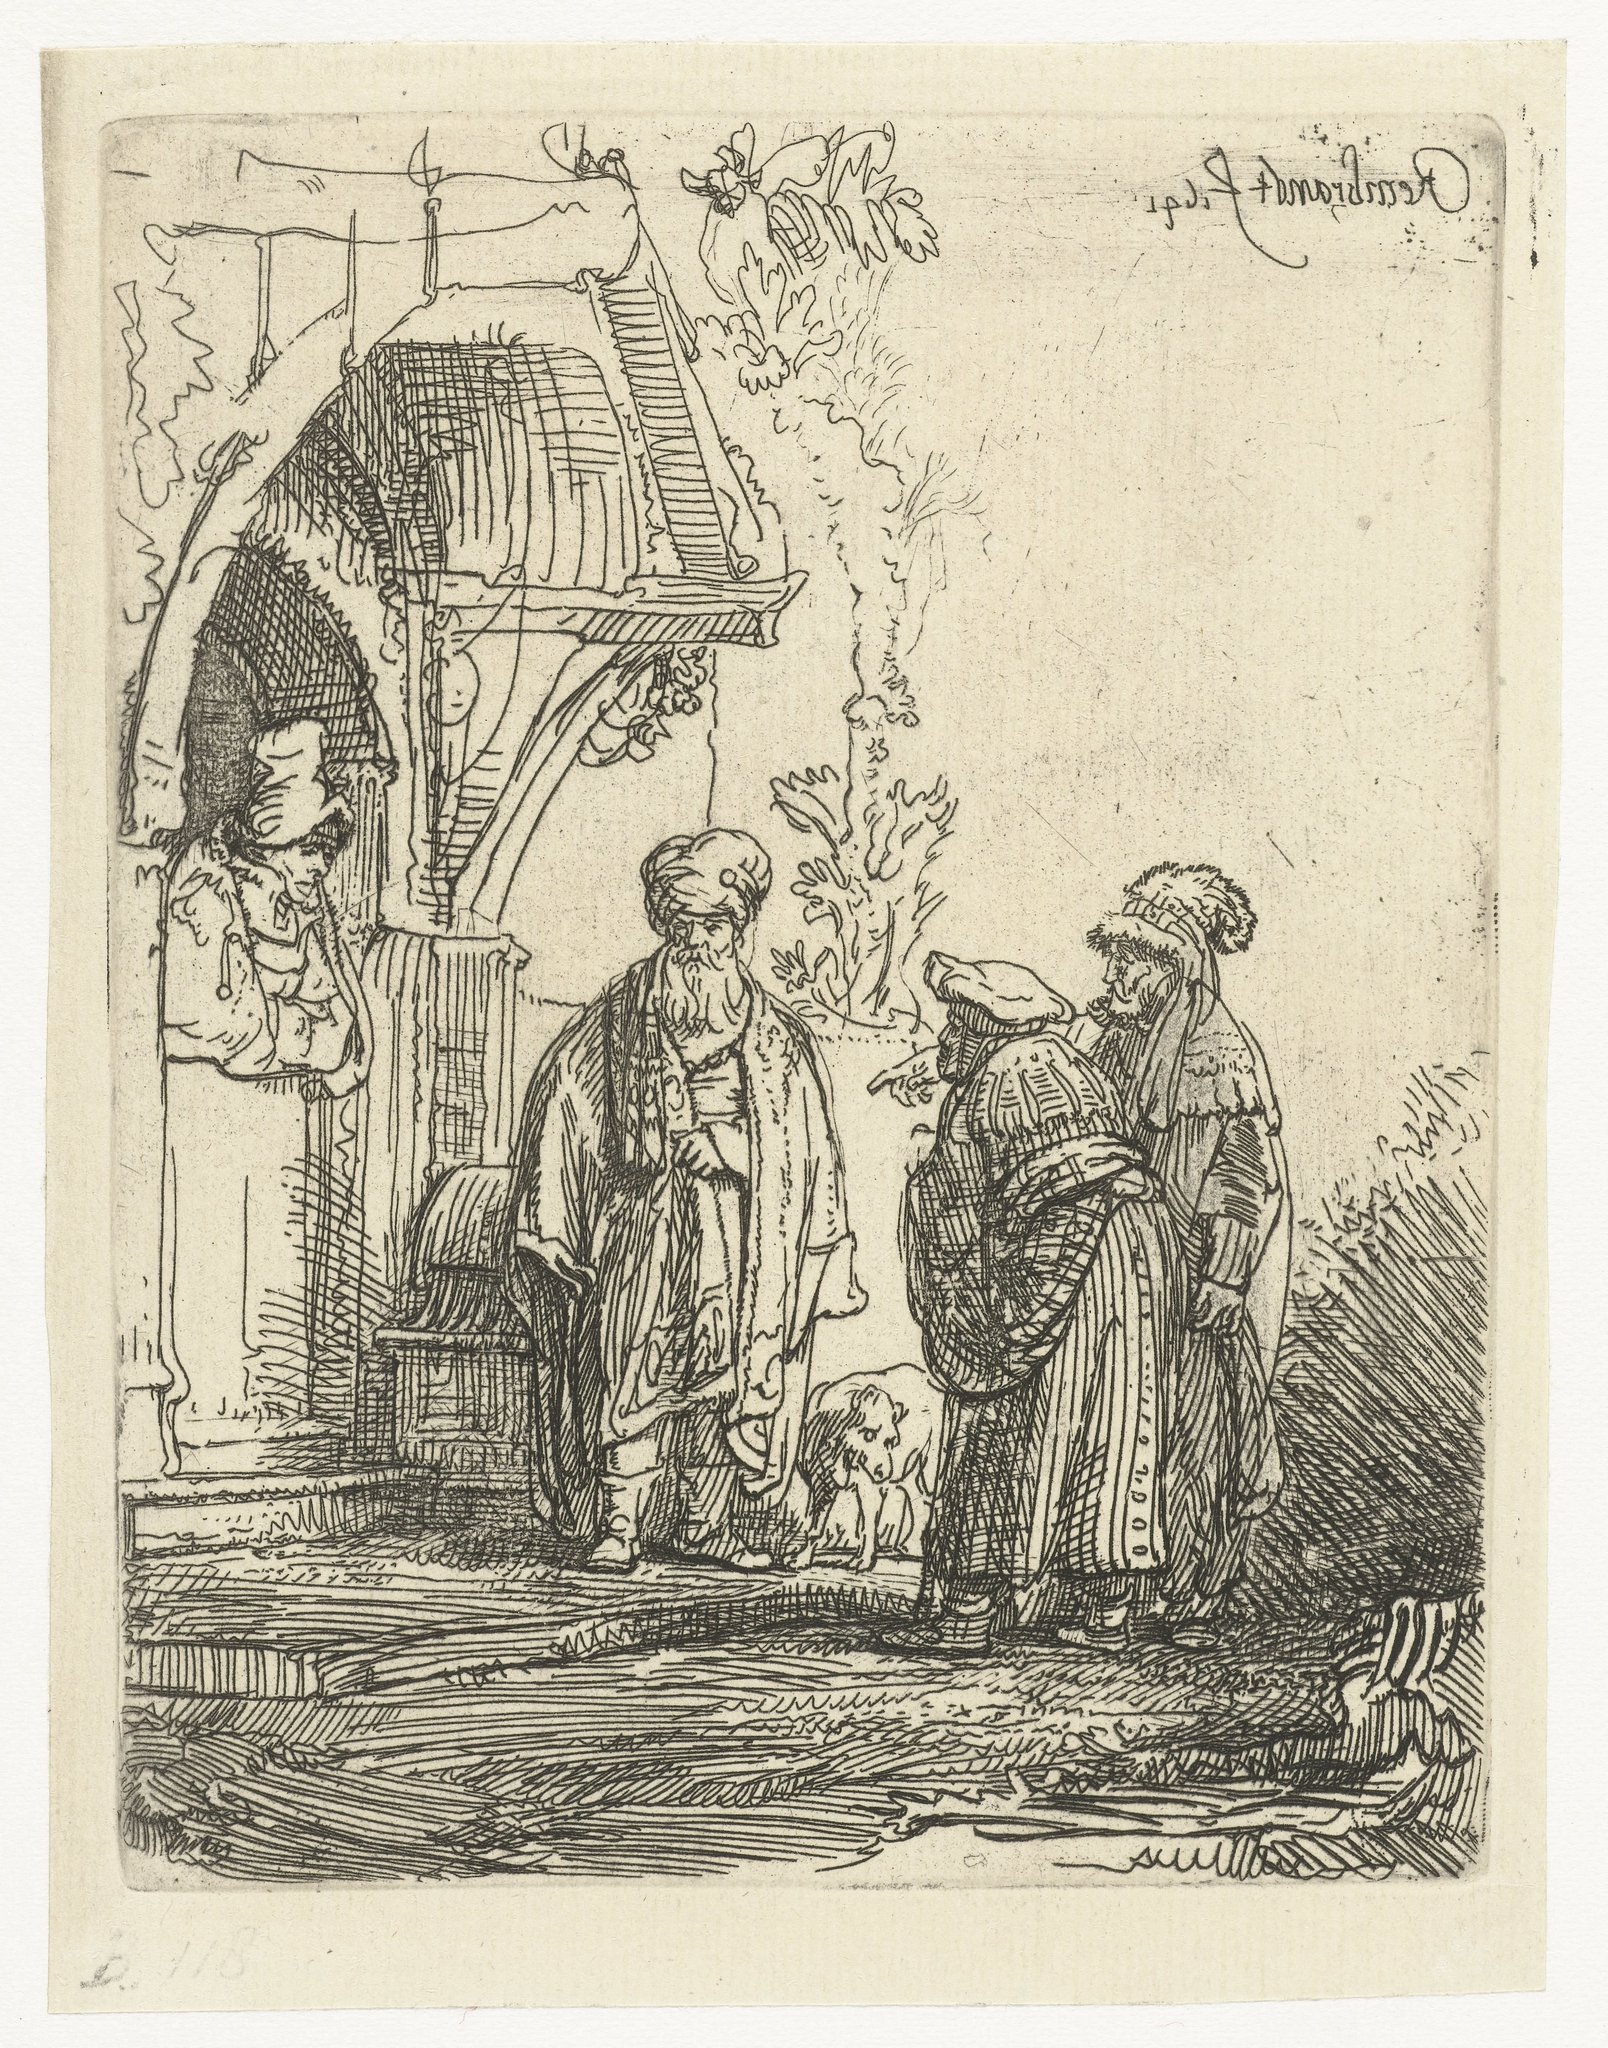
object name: print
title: Three oriental figures (Jacob and Laban?)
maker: rembrandt van rijn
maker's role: draughtsman, painter, print maker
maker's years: 1606-1669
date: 1641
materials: paper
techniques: drypoint, etching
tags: the partnership with laban ~ story of jacob (genesis 30:25-43)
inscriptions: signature and date: ‘Rembrandt f. 1641 (spiegelbeeldig)’, inscription: ‘Coppier’